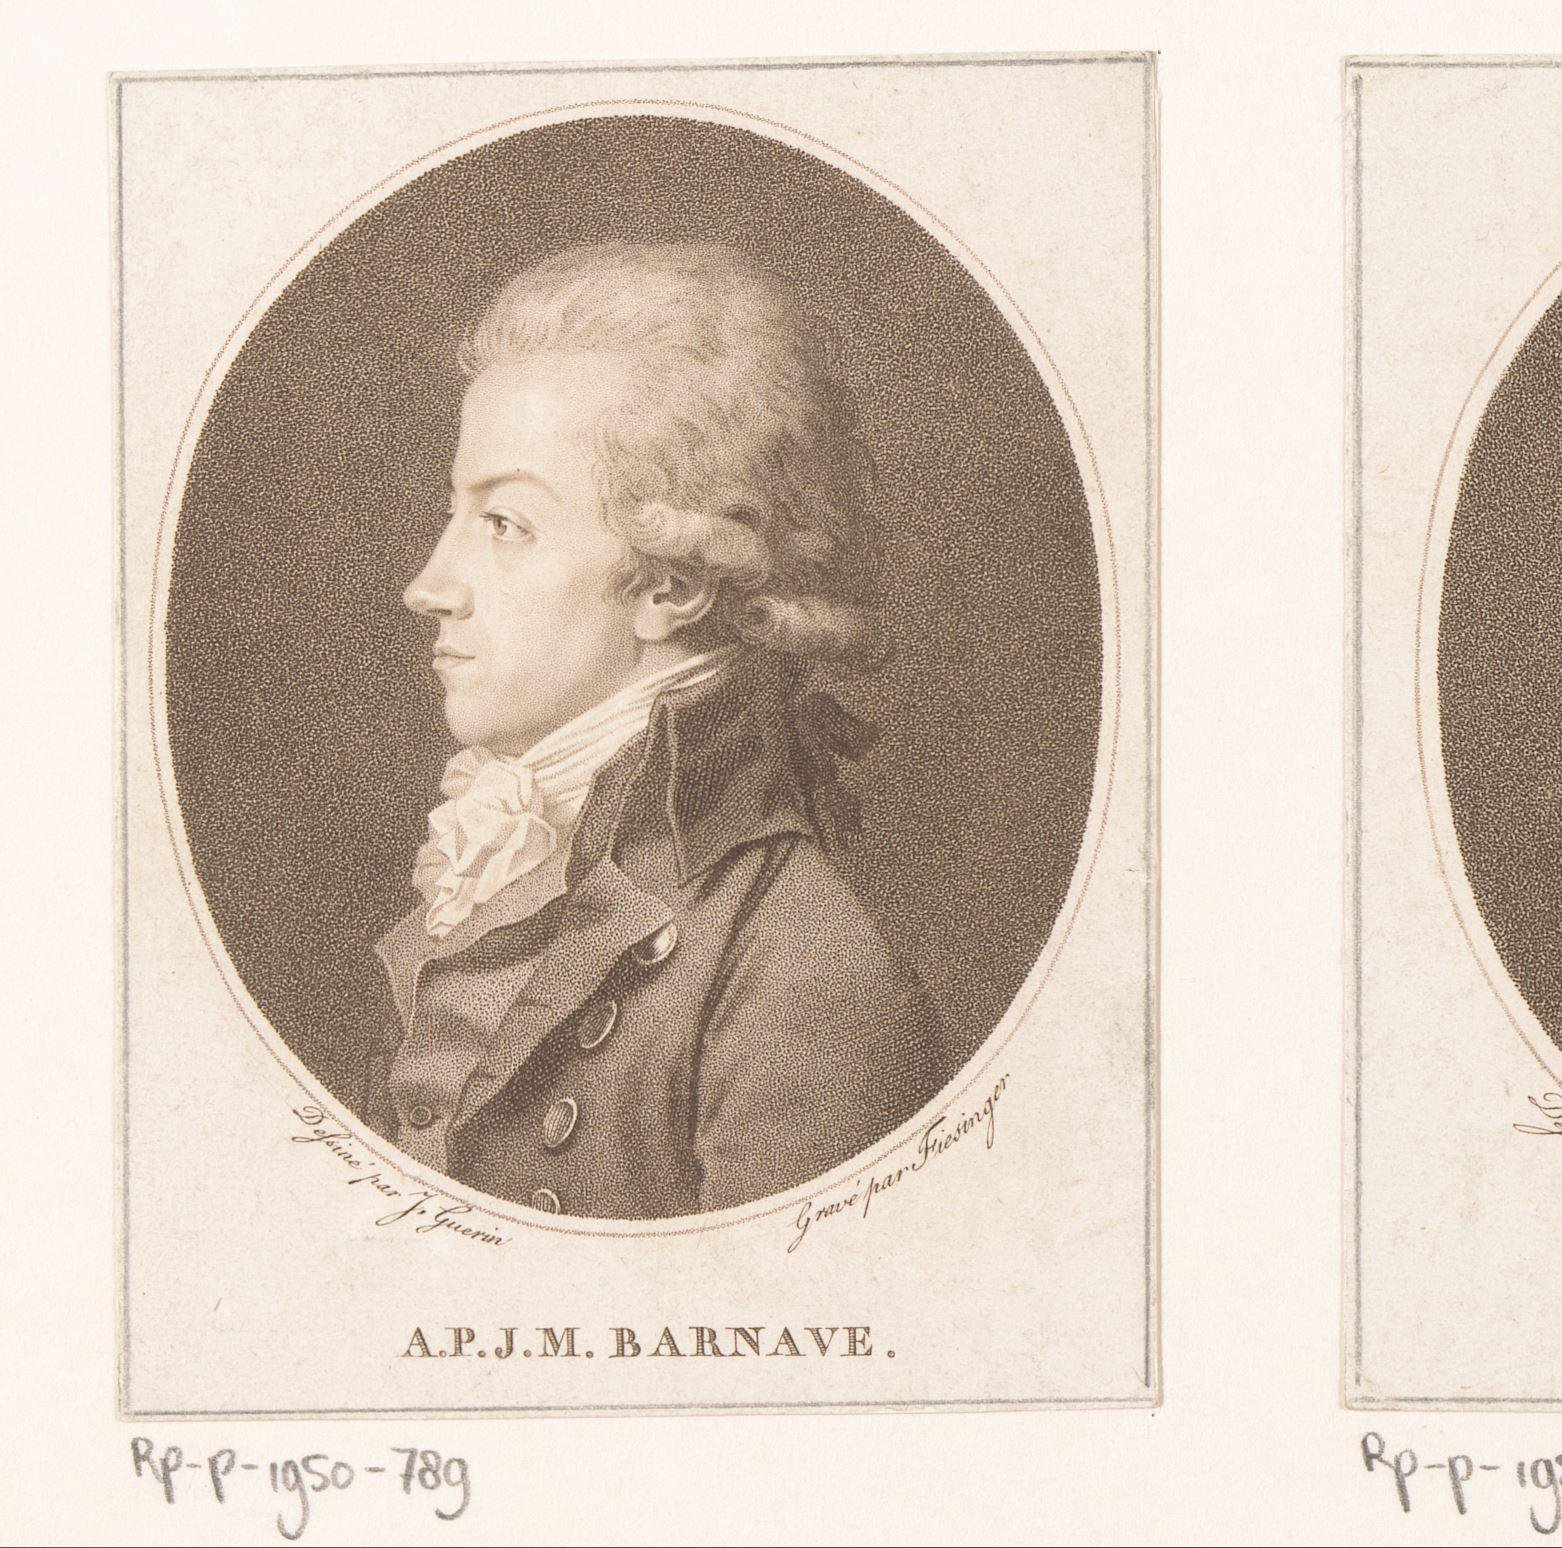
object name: print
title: Portret van Antoine Pierre Joseph Marie Barnave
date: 1790-1807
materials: paper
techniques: stippling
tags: politician, historical persons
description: Prent uit een serie portretten van Franse revolutionairen.